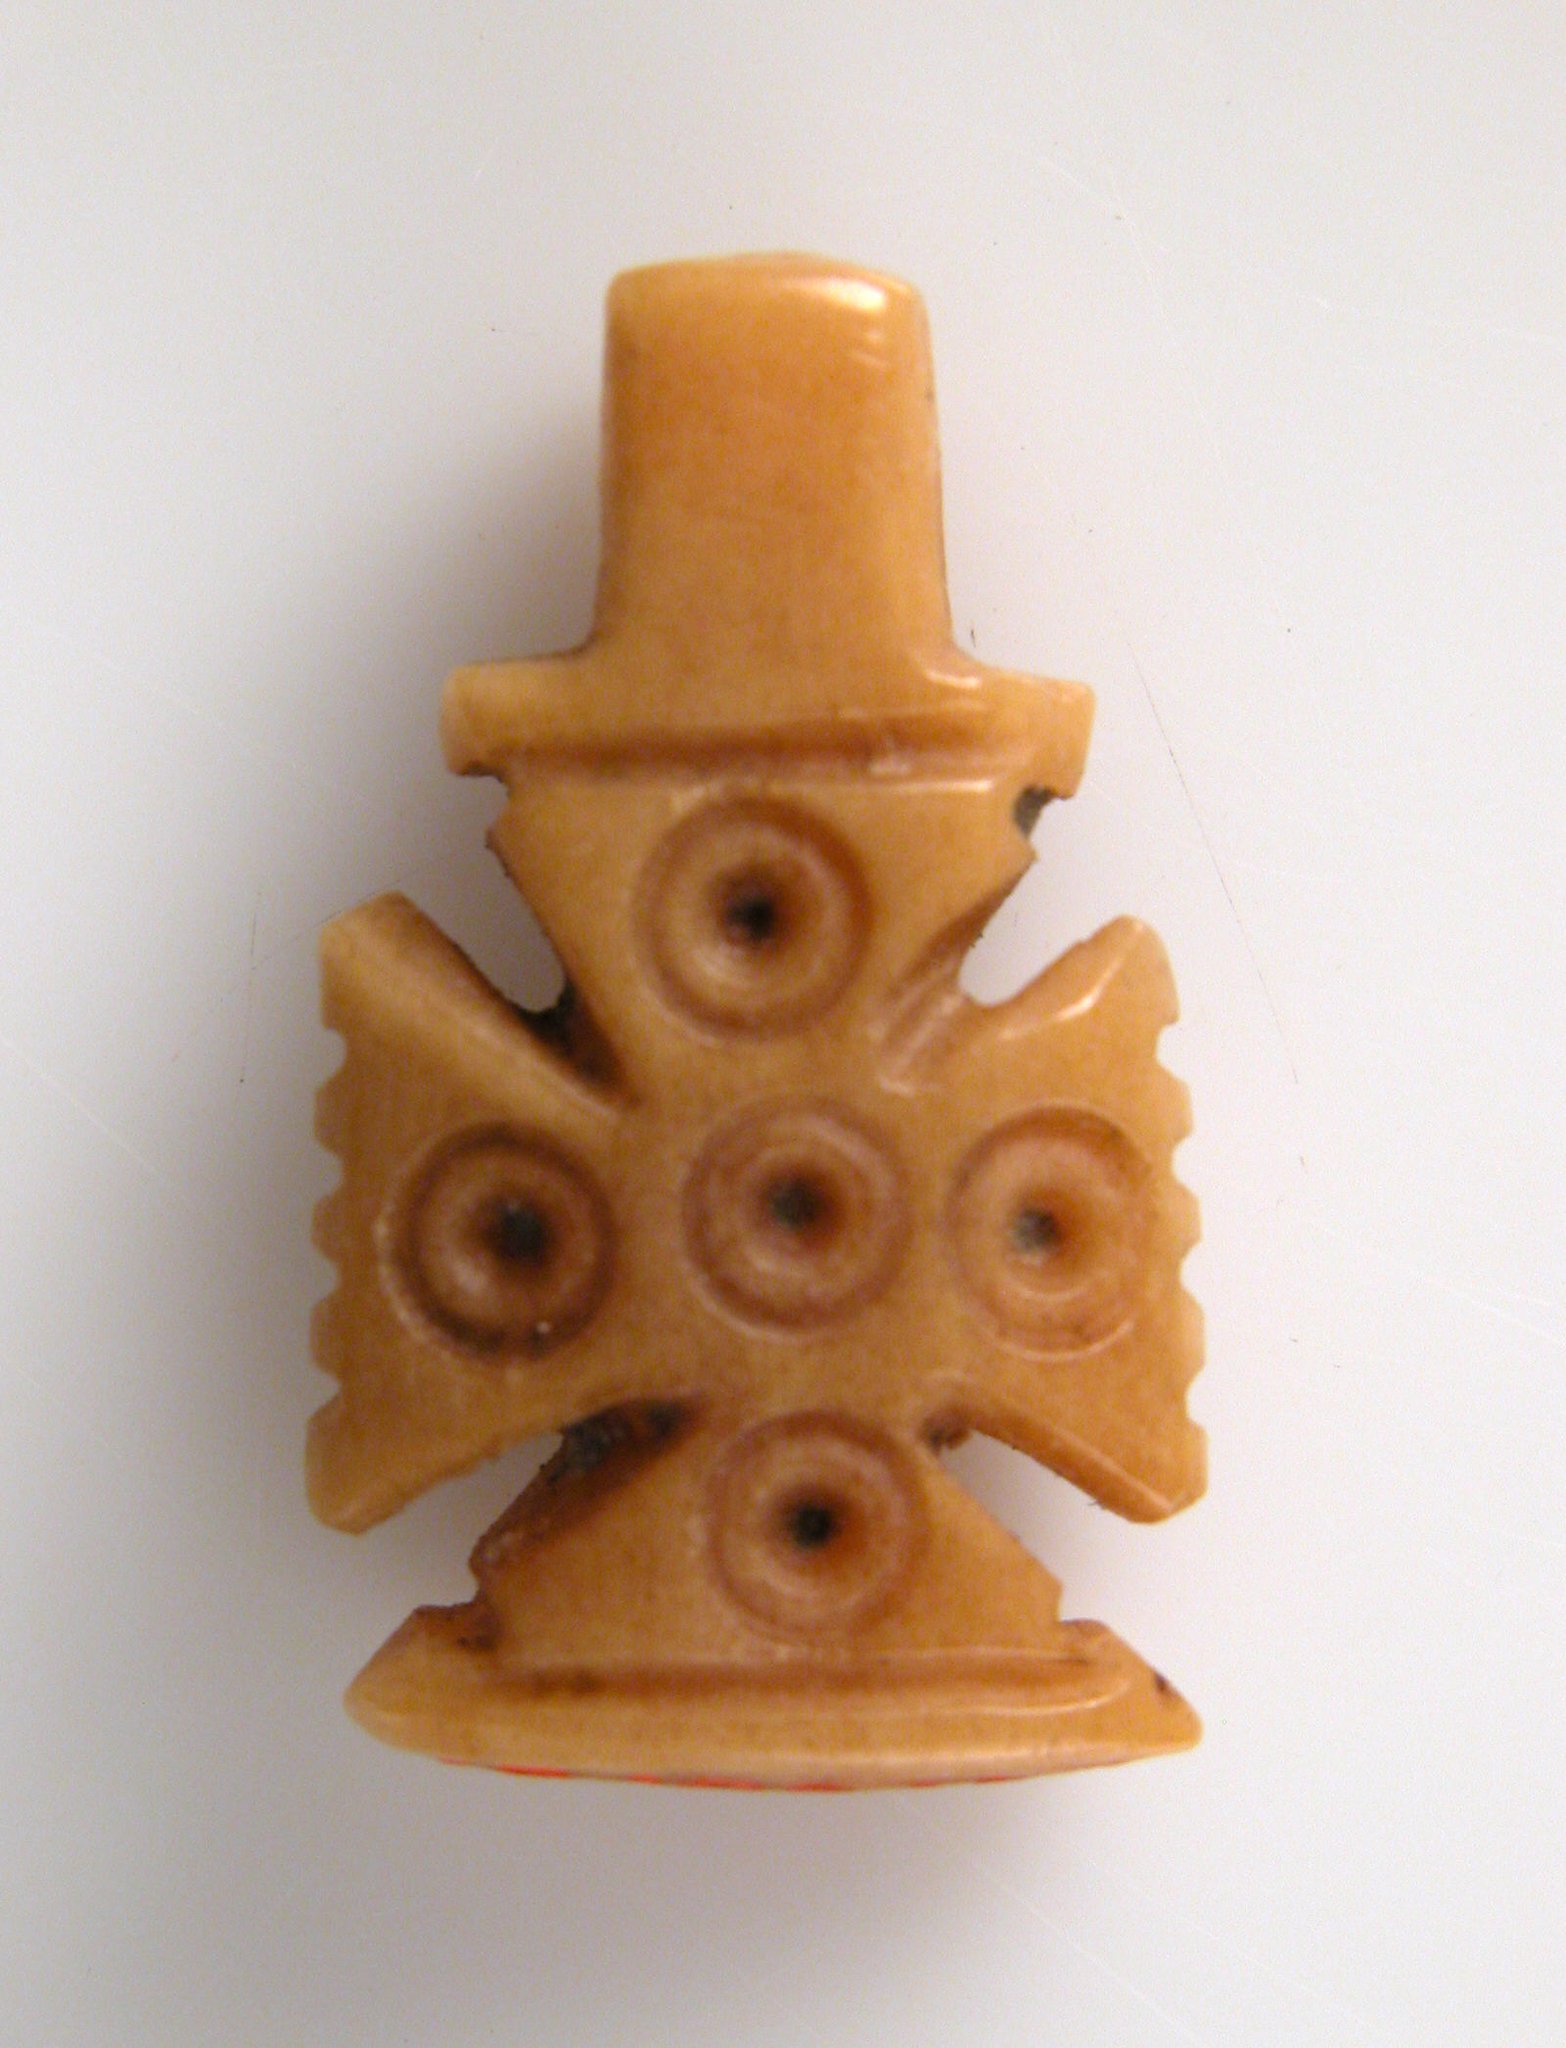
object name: pendant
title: Pendant Cross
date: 401-700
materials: bone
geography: egypt